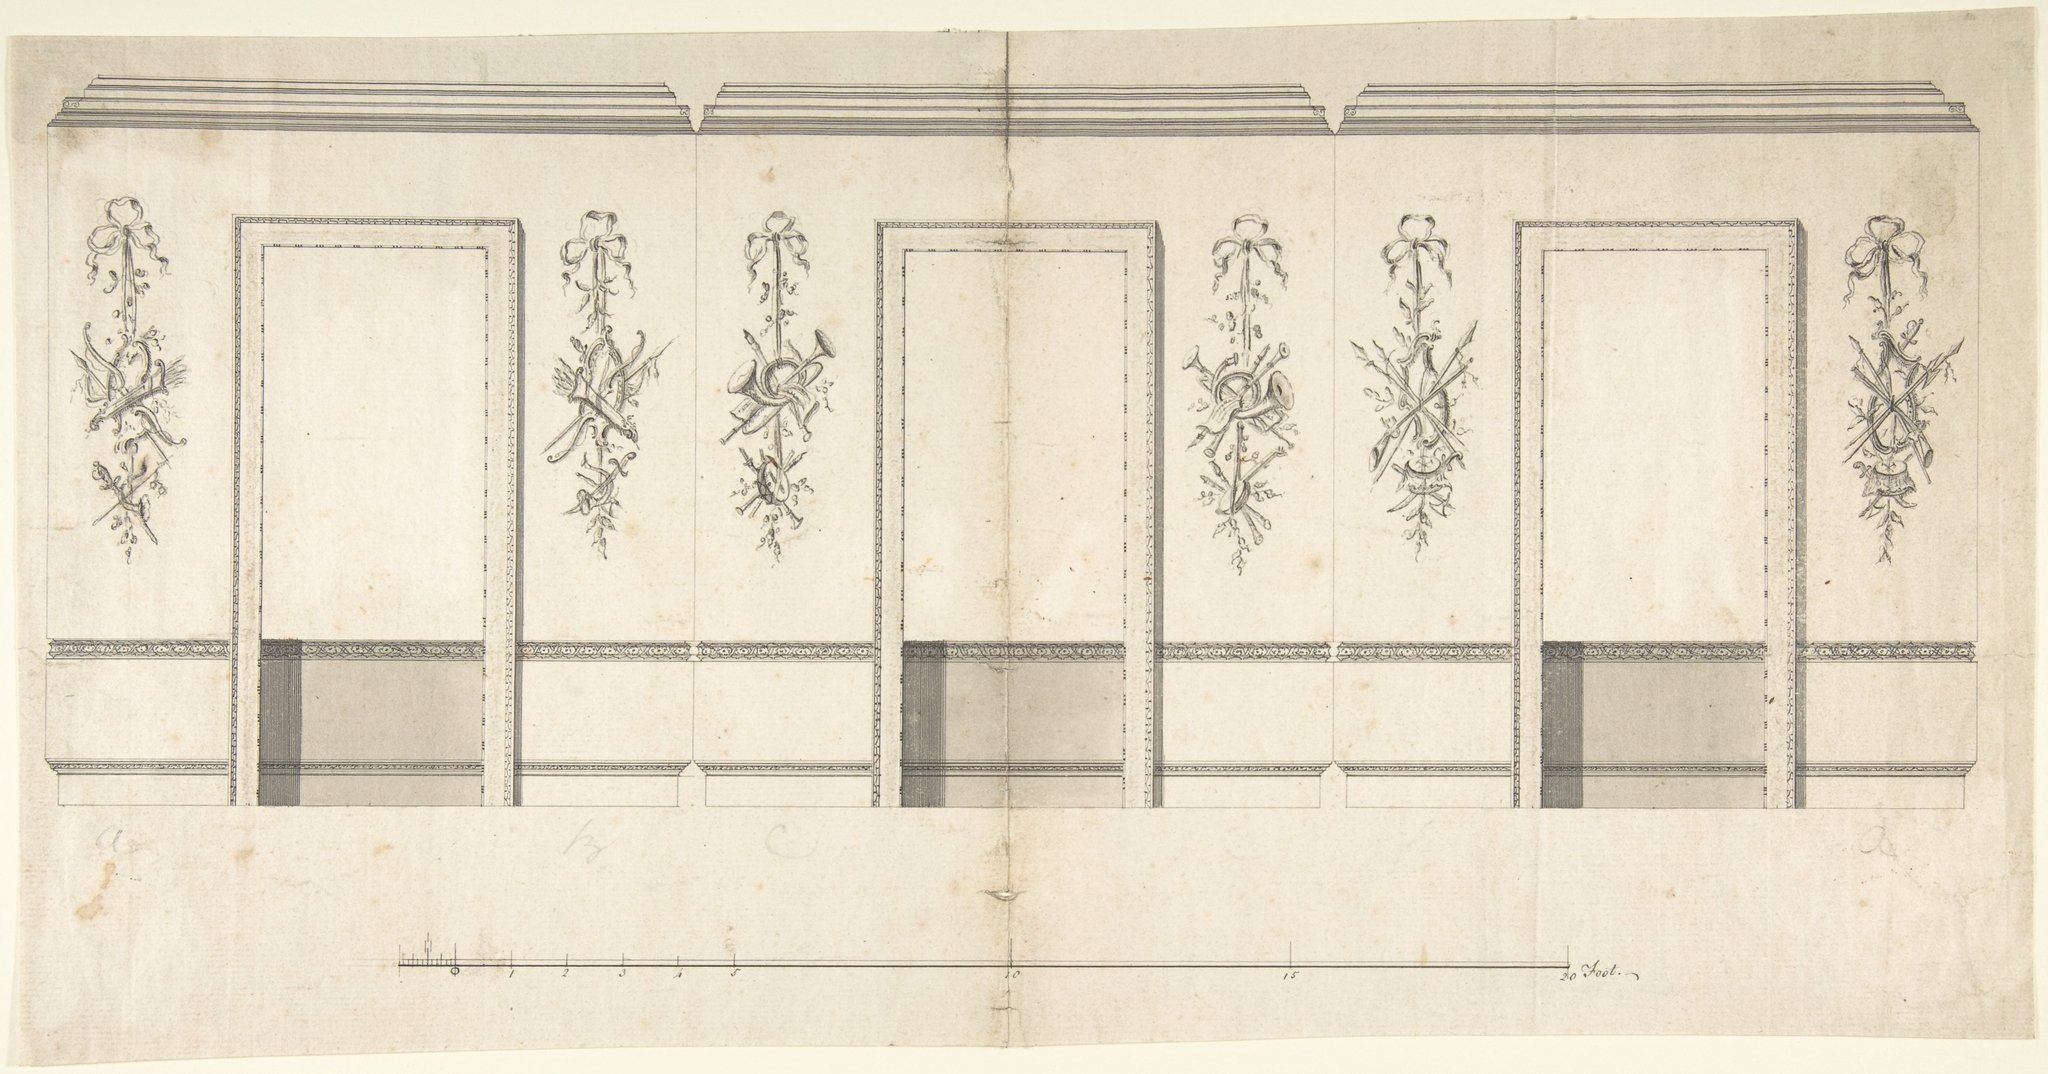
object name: drawing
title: Wall Decorated with Musical and Military Trophies and Three Windows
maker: anonymous, british, 18th century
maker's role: artist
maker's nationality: british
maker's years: 1700-1800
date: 1701-1800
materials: ink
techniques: brush, pen, wash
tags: architecture,windows,trophies